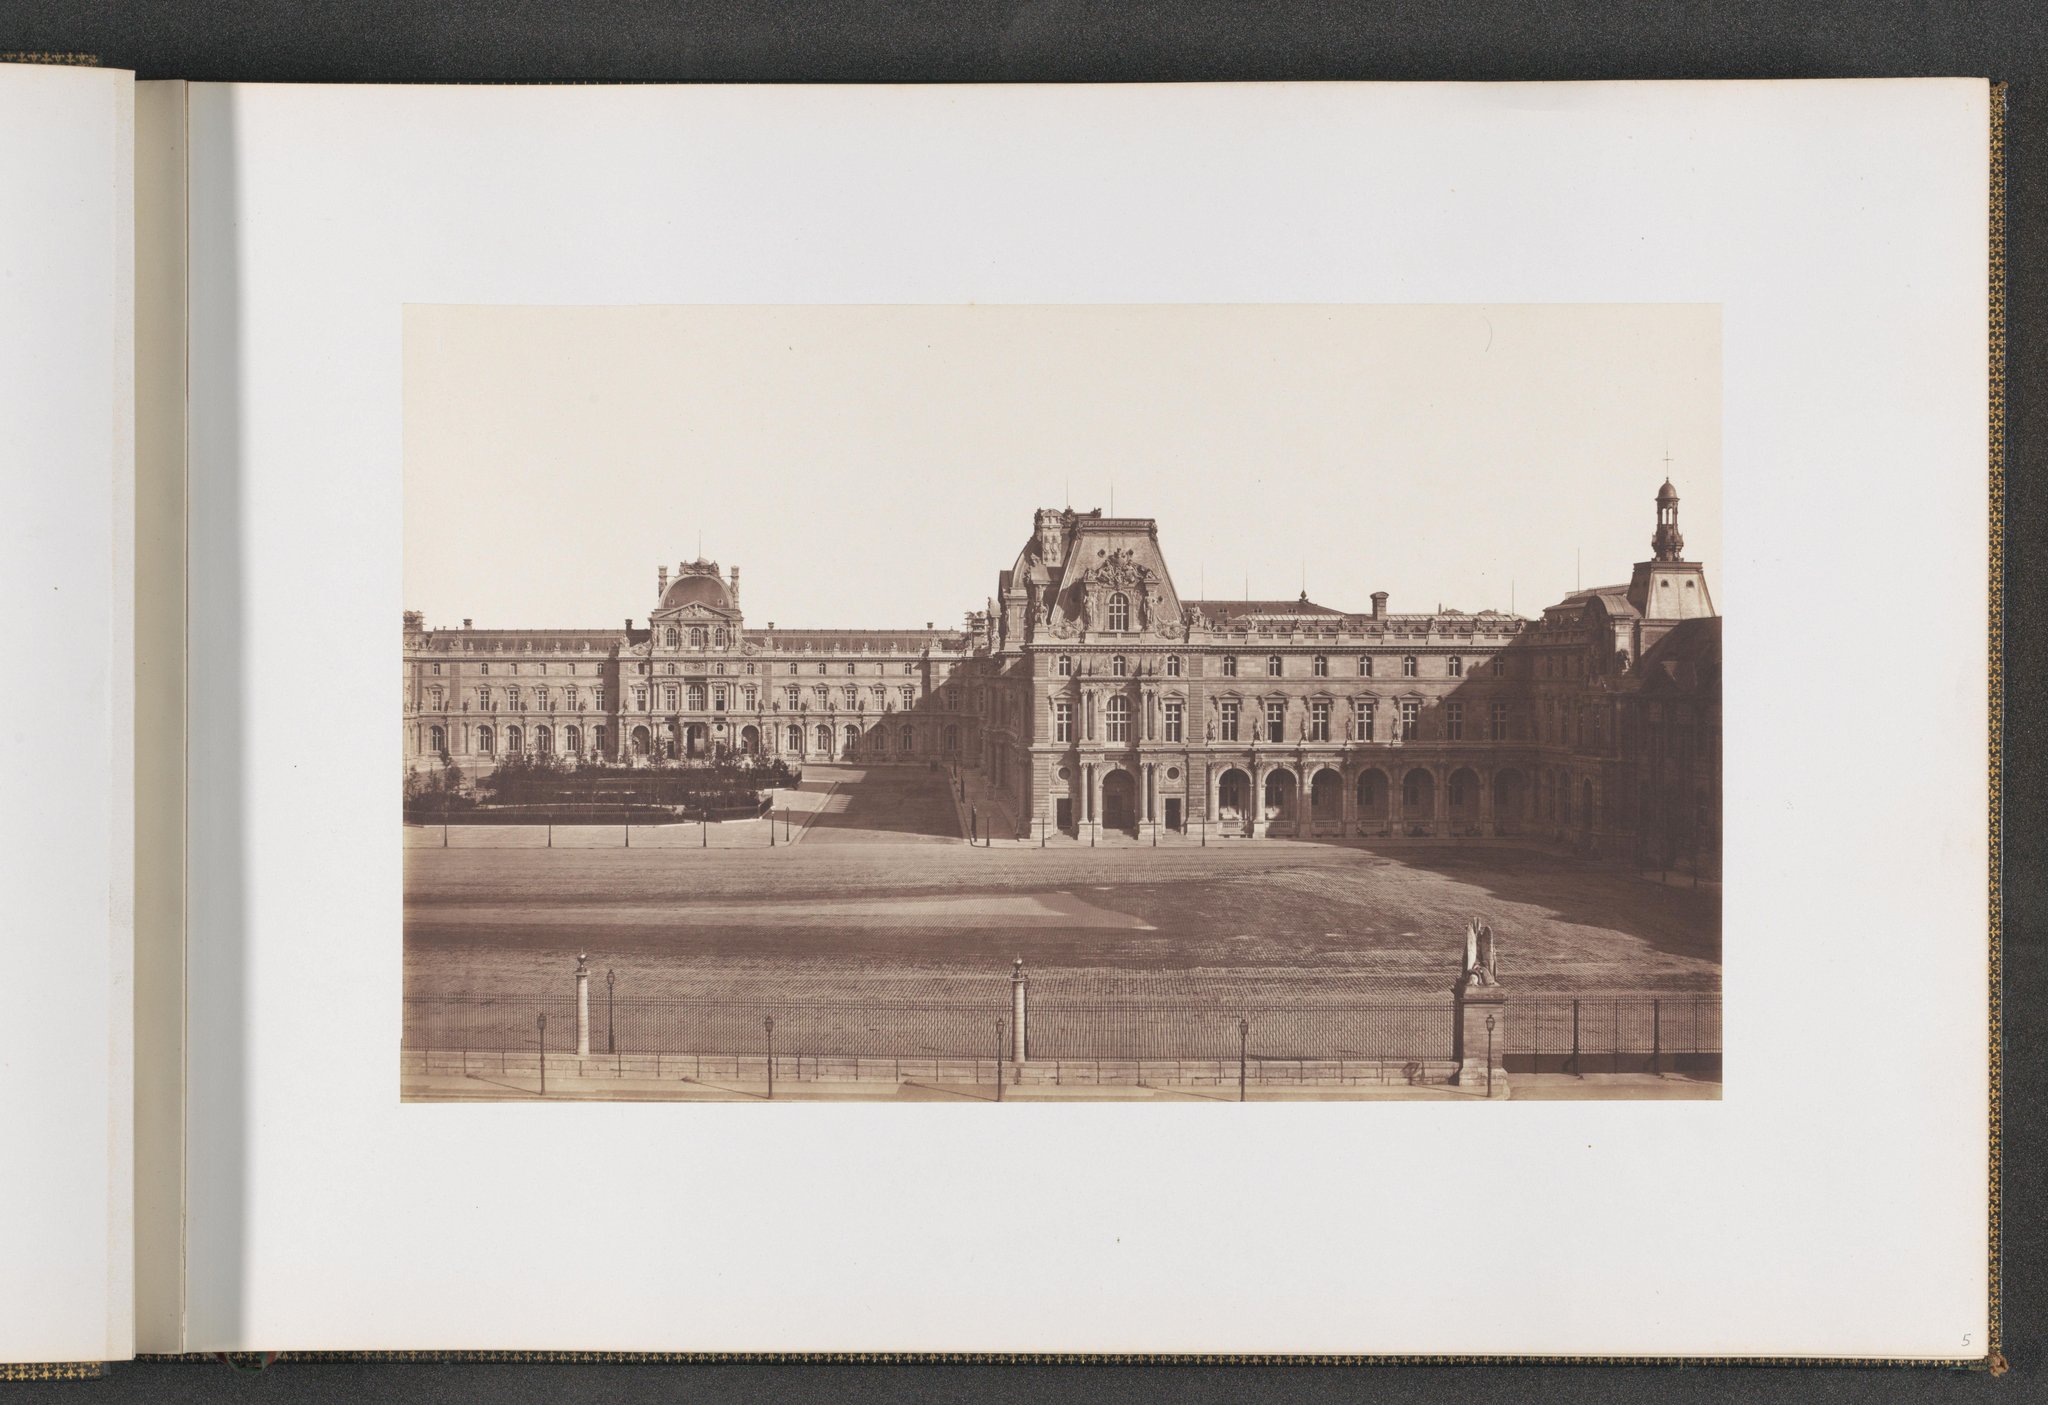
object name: photograph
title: Cour Napoléon gezien vanaf de Tuileries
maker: édouard denis baldus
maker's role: fotograaf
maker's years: 1813-1889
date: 1857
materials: paper, photographic support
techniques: salted paper print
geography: paris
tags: permanent exhibition, museum, façade (of house or building), paris, tuileries palace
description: Onderdeel van Réunion des Tuileries au Louvre 1852-1857, album 2.